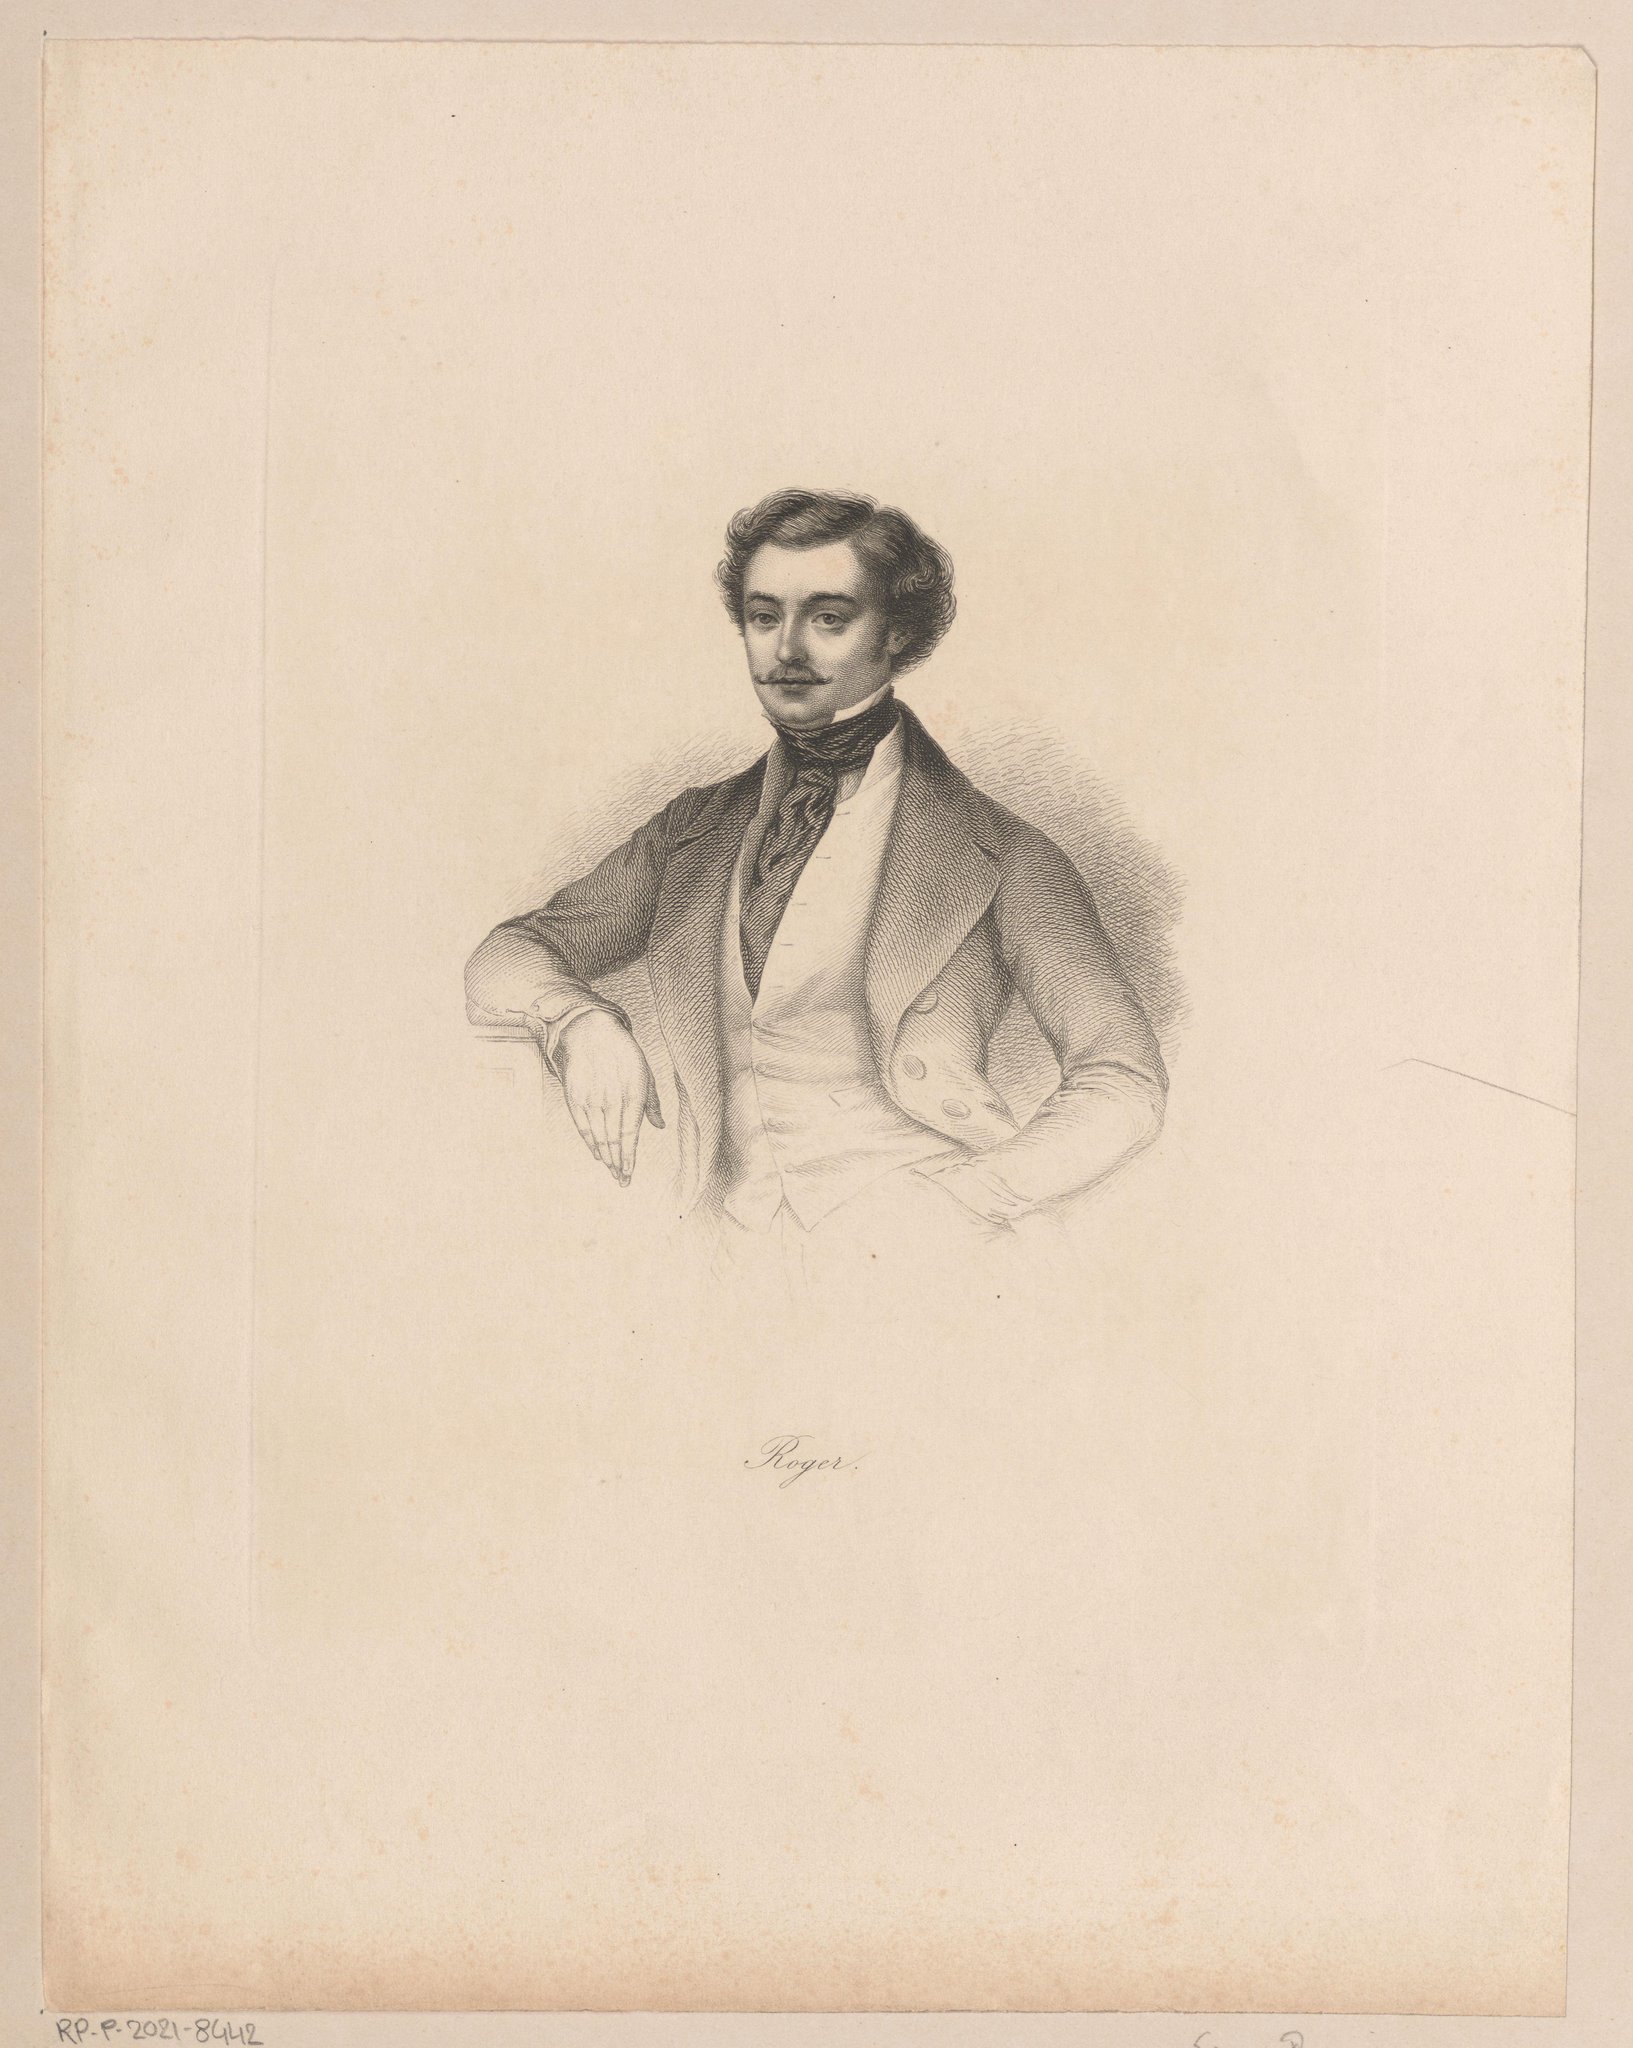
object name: print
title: Portret van Gustave-Hippolyte Roger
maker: Anonymous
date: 1838-1899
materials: paper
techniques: engraving, etching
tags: historical persons